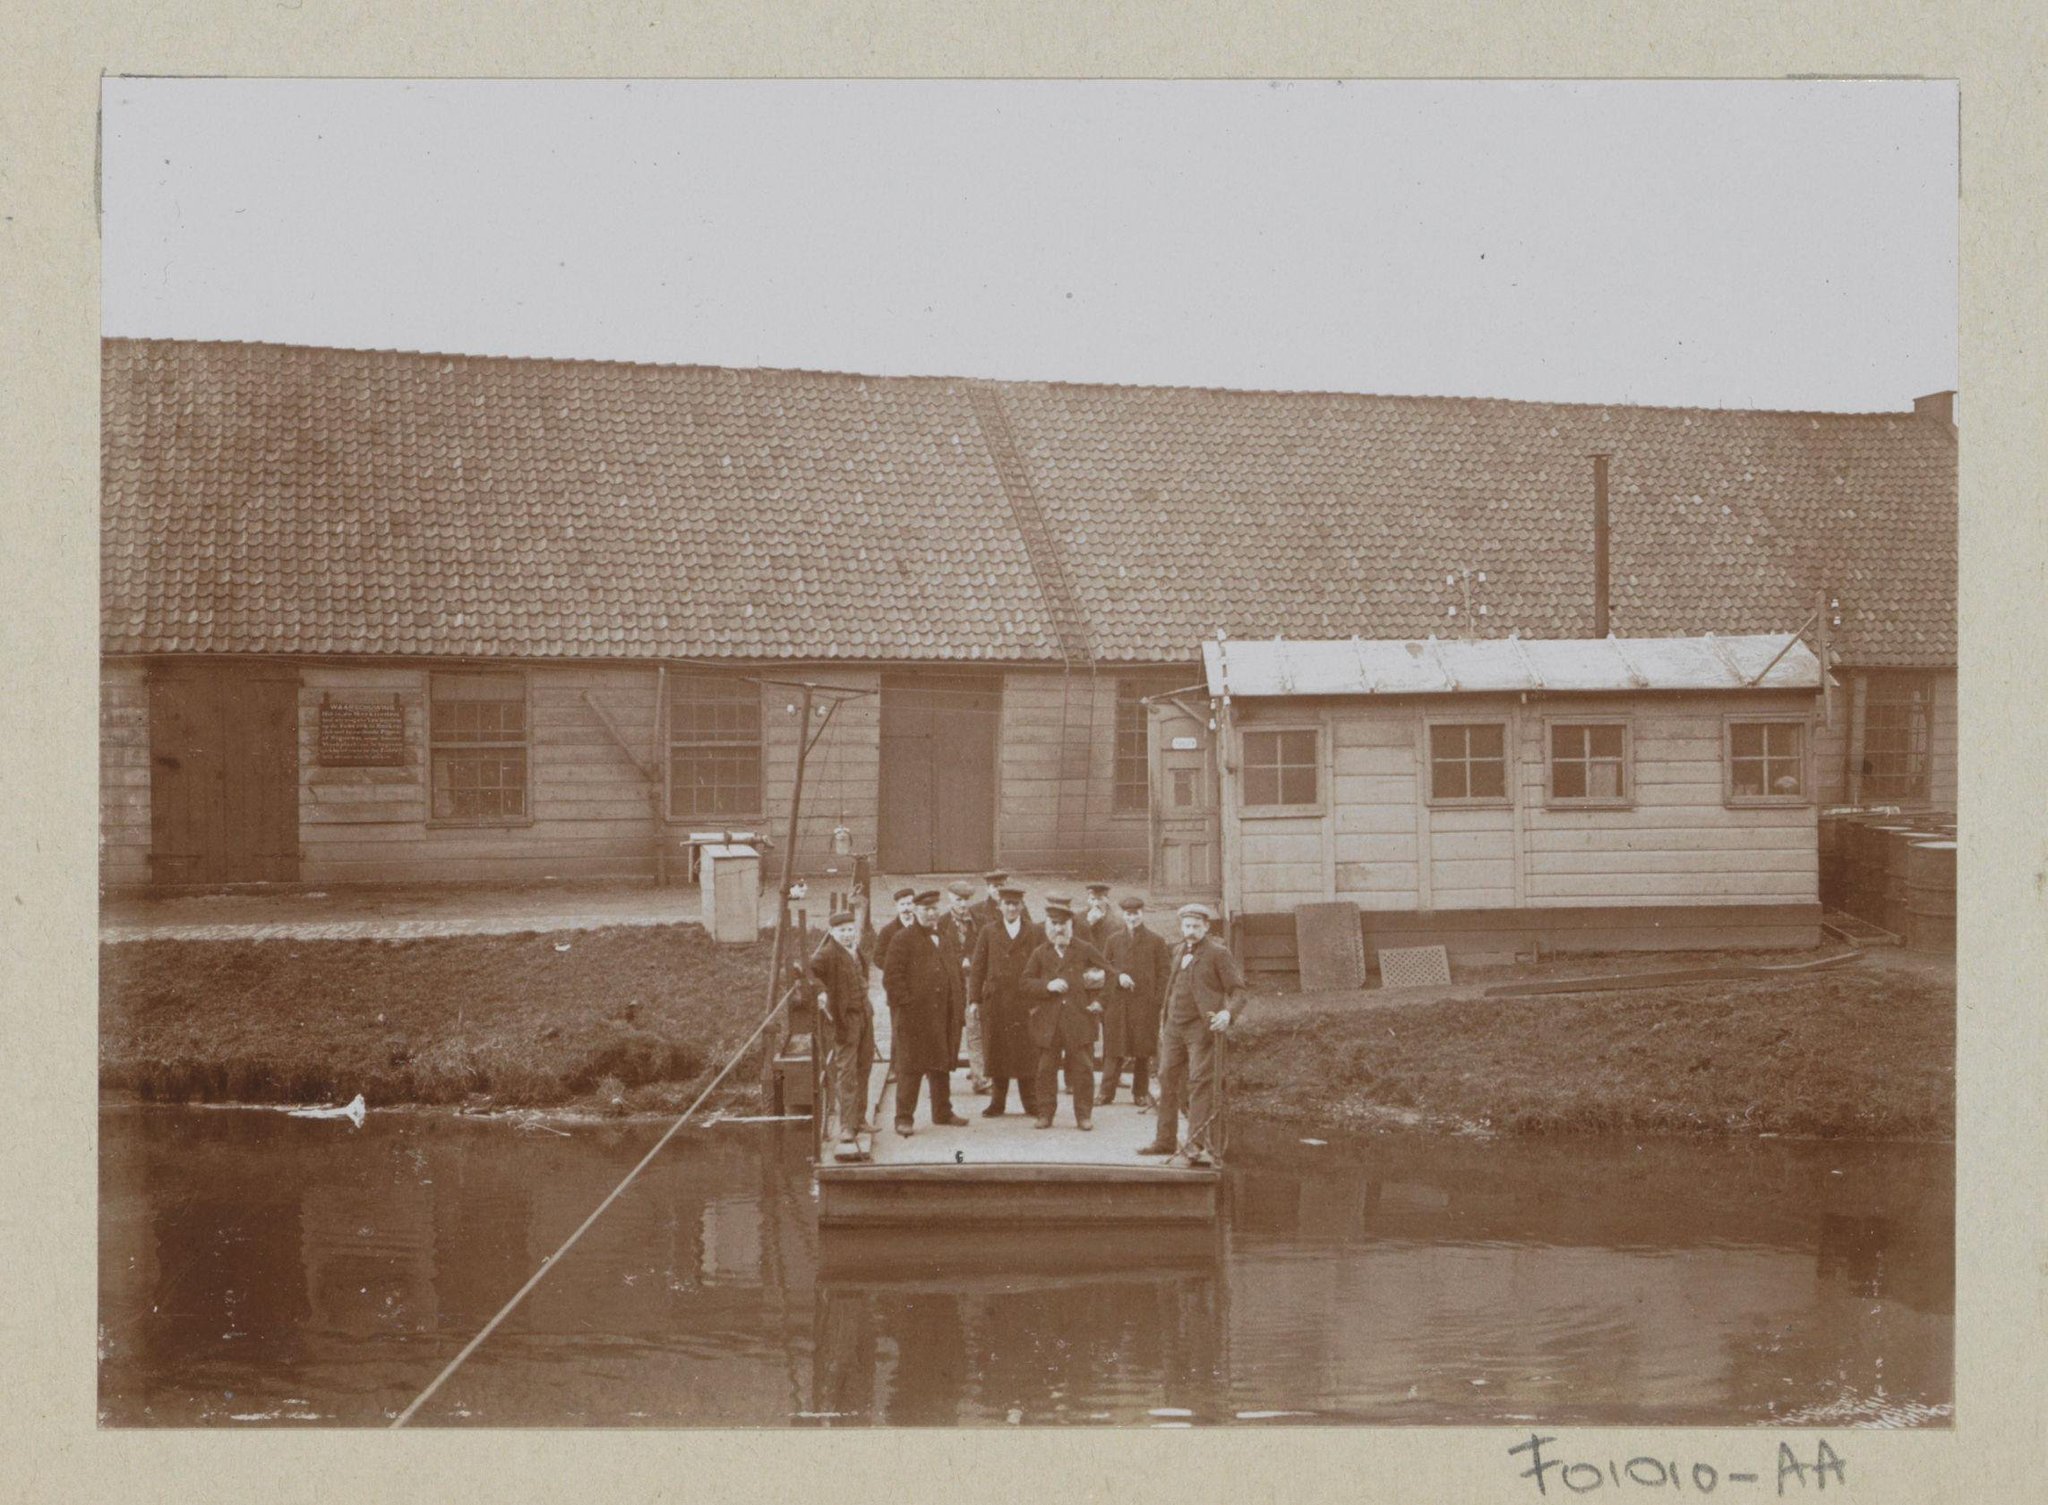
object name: photograph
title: Mannen, vermoedelijk werknemers, staand op een aanlegsteiger bij een fabriekshal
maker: Anonymous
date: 1900-1910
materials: photographic support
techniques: collodion silver print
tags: factory-building, pier, quay, wharf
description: Onderdeel van Familiealbum met onder meer foto's van Wijnhandel Kraaij & Co. Bordeaux-Amsterdam.